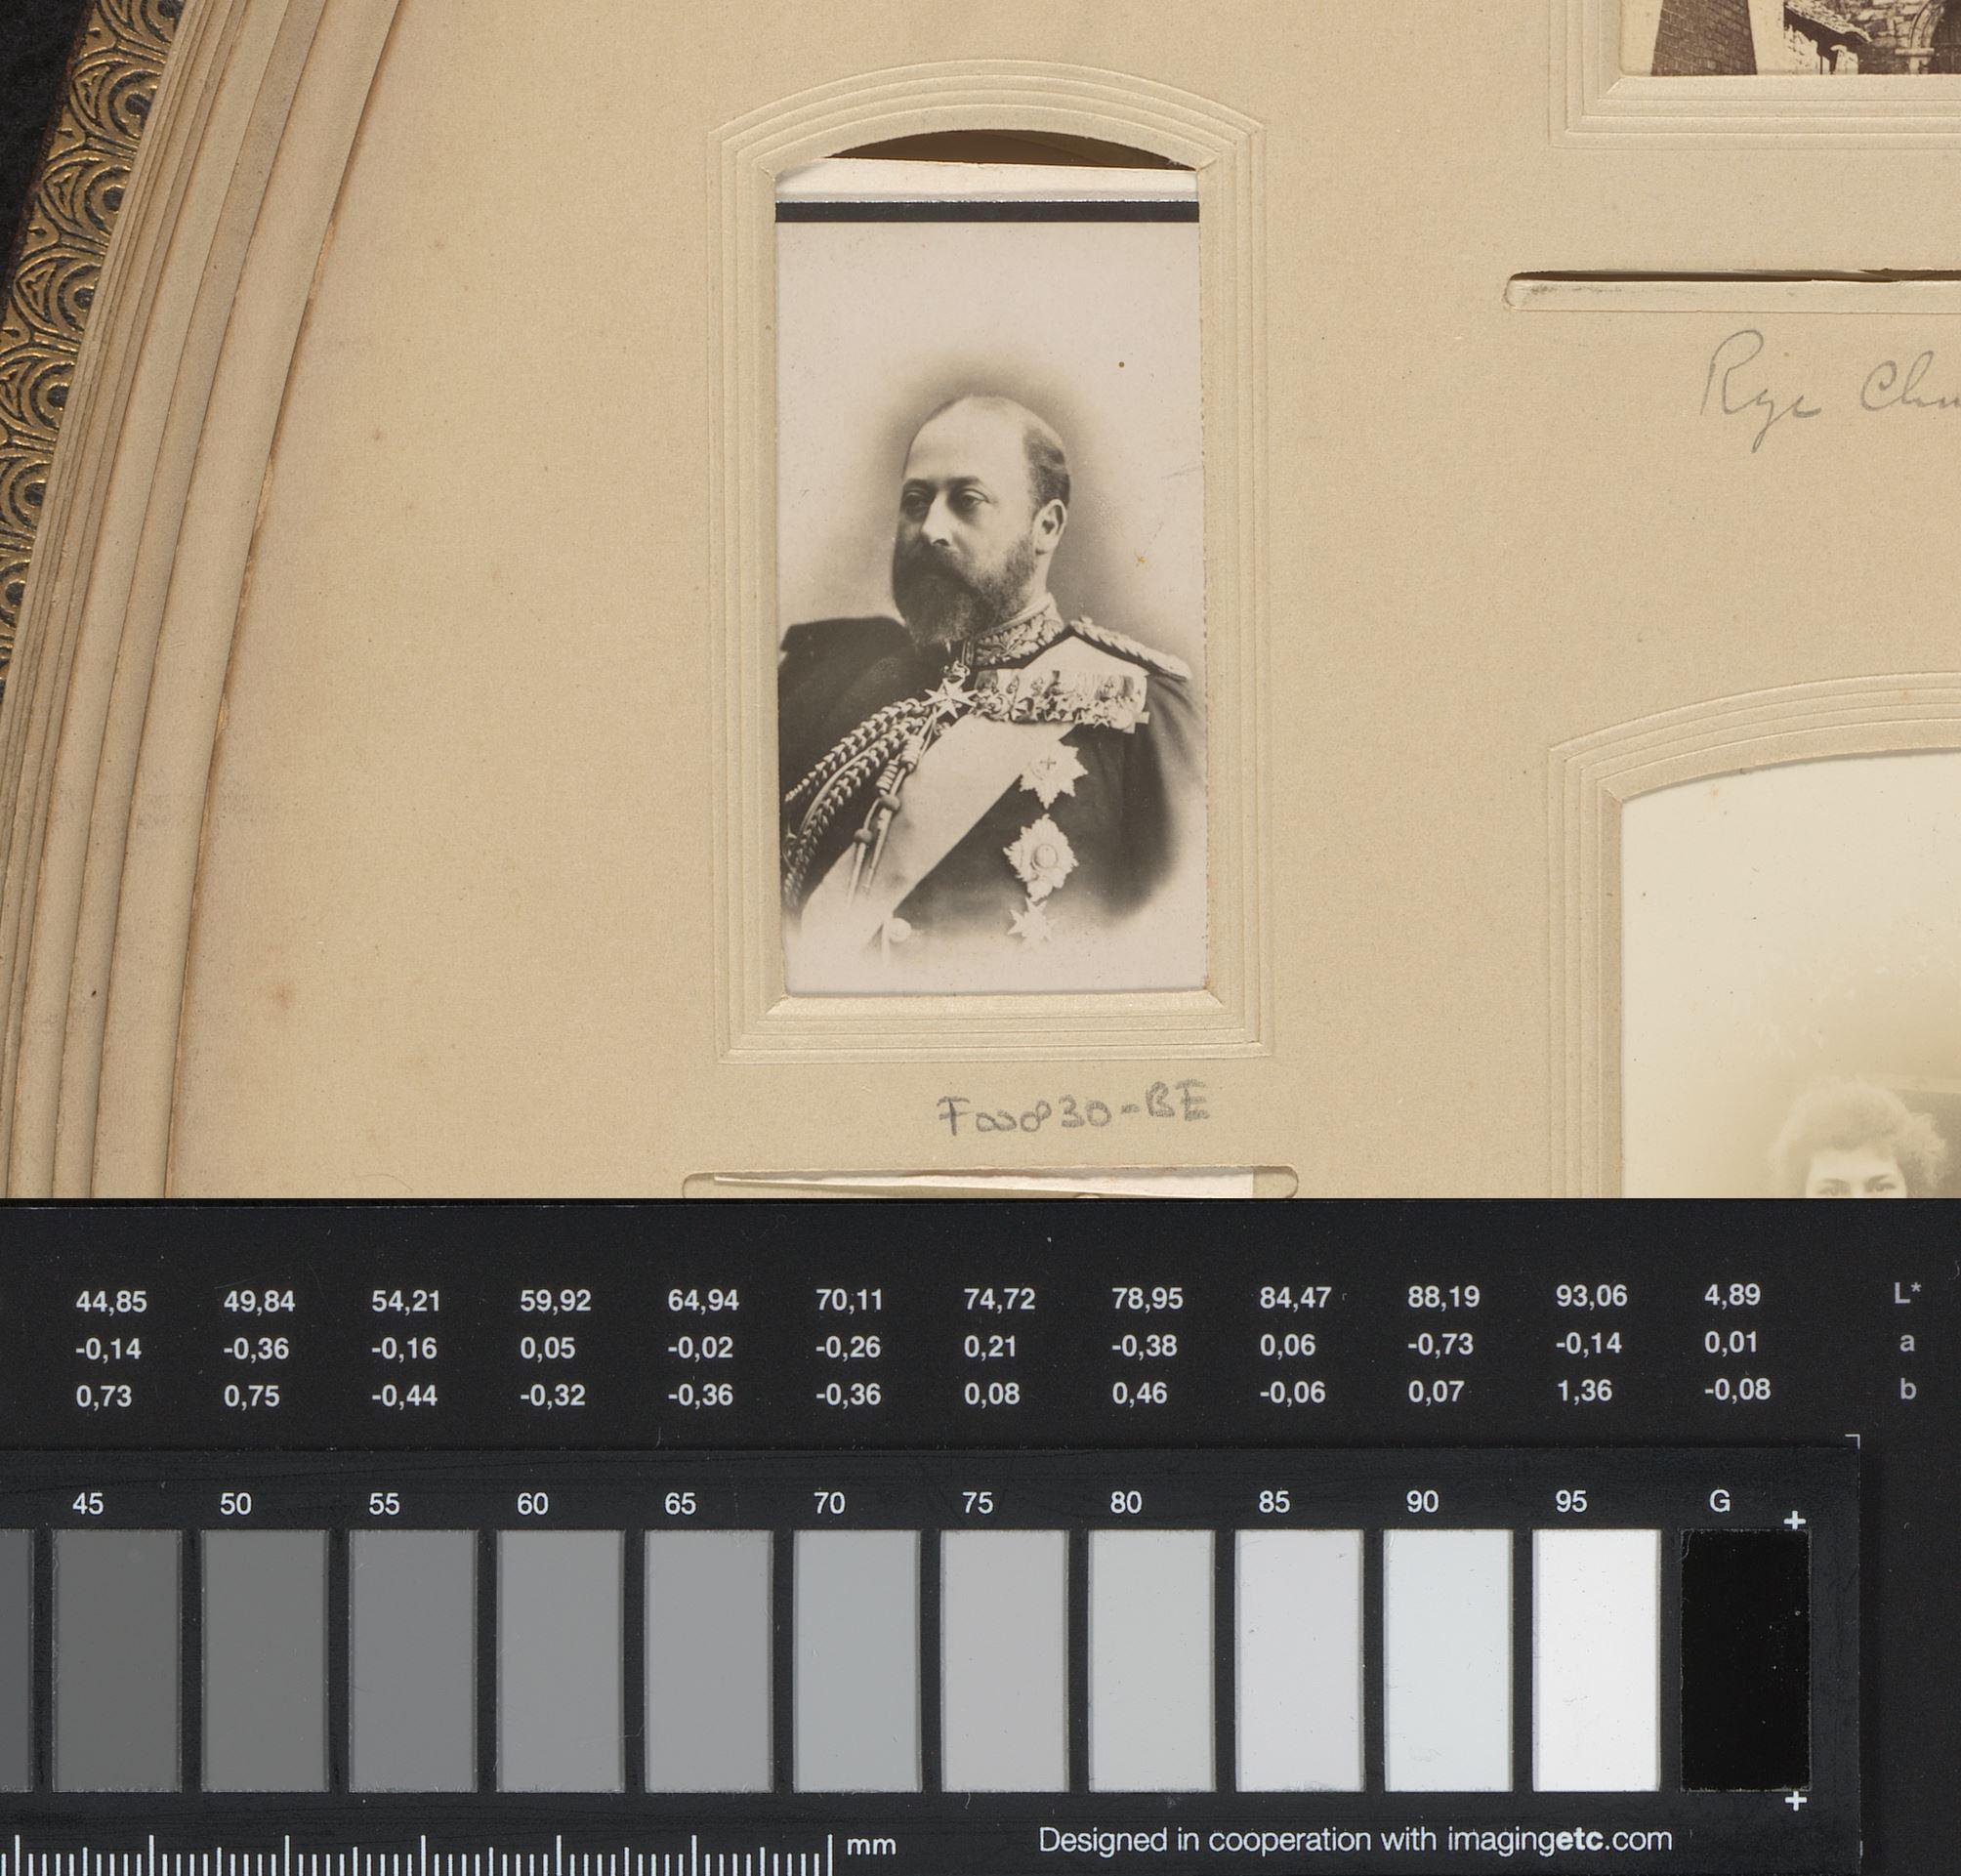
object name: photograph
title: Portret van koning Eduard VII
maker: Anonymous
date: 1890-1910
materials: cardboard, photographic support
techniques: gelatin silver print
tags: london, adult man, historical persons, king